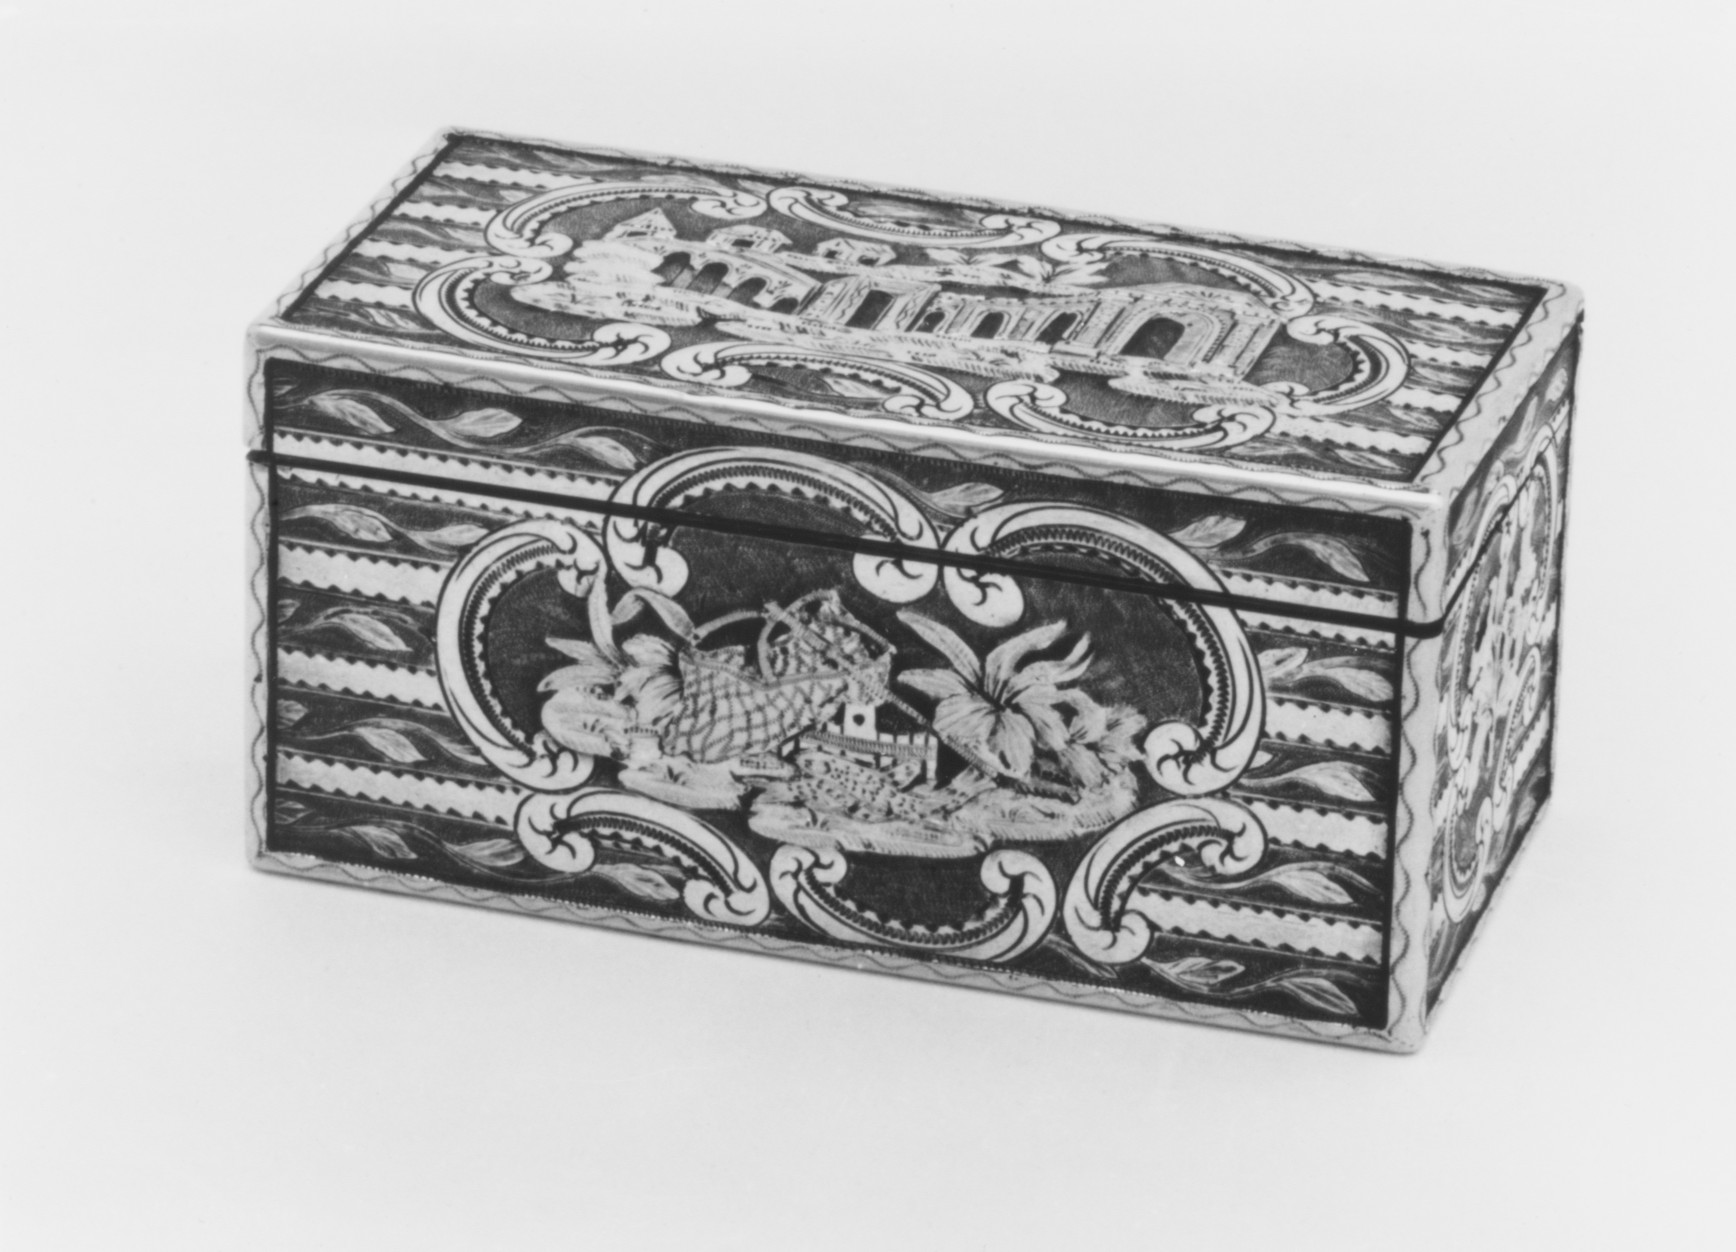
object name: snuffbox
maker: charles le bastier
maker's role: maker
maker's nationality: french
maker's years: 1724-1783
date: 1760-1761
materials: gilt, silver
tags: flowers